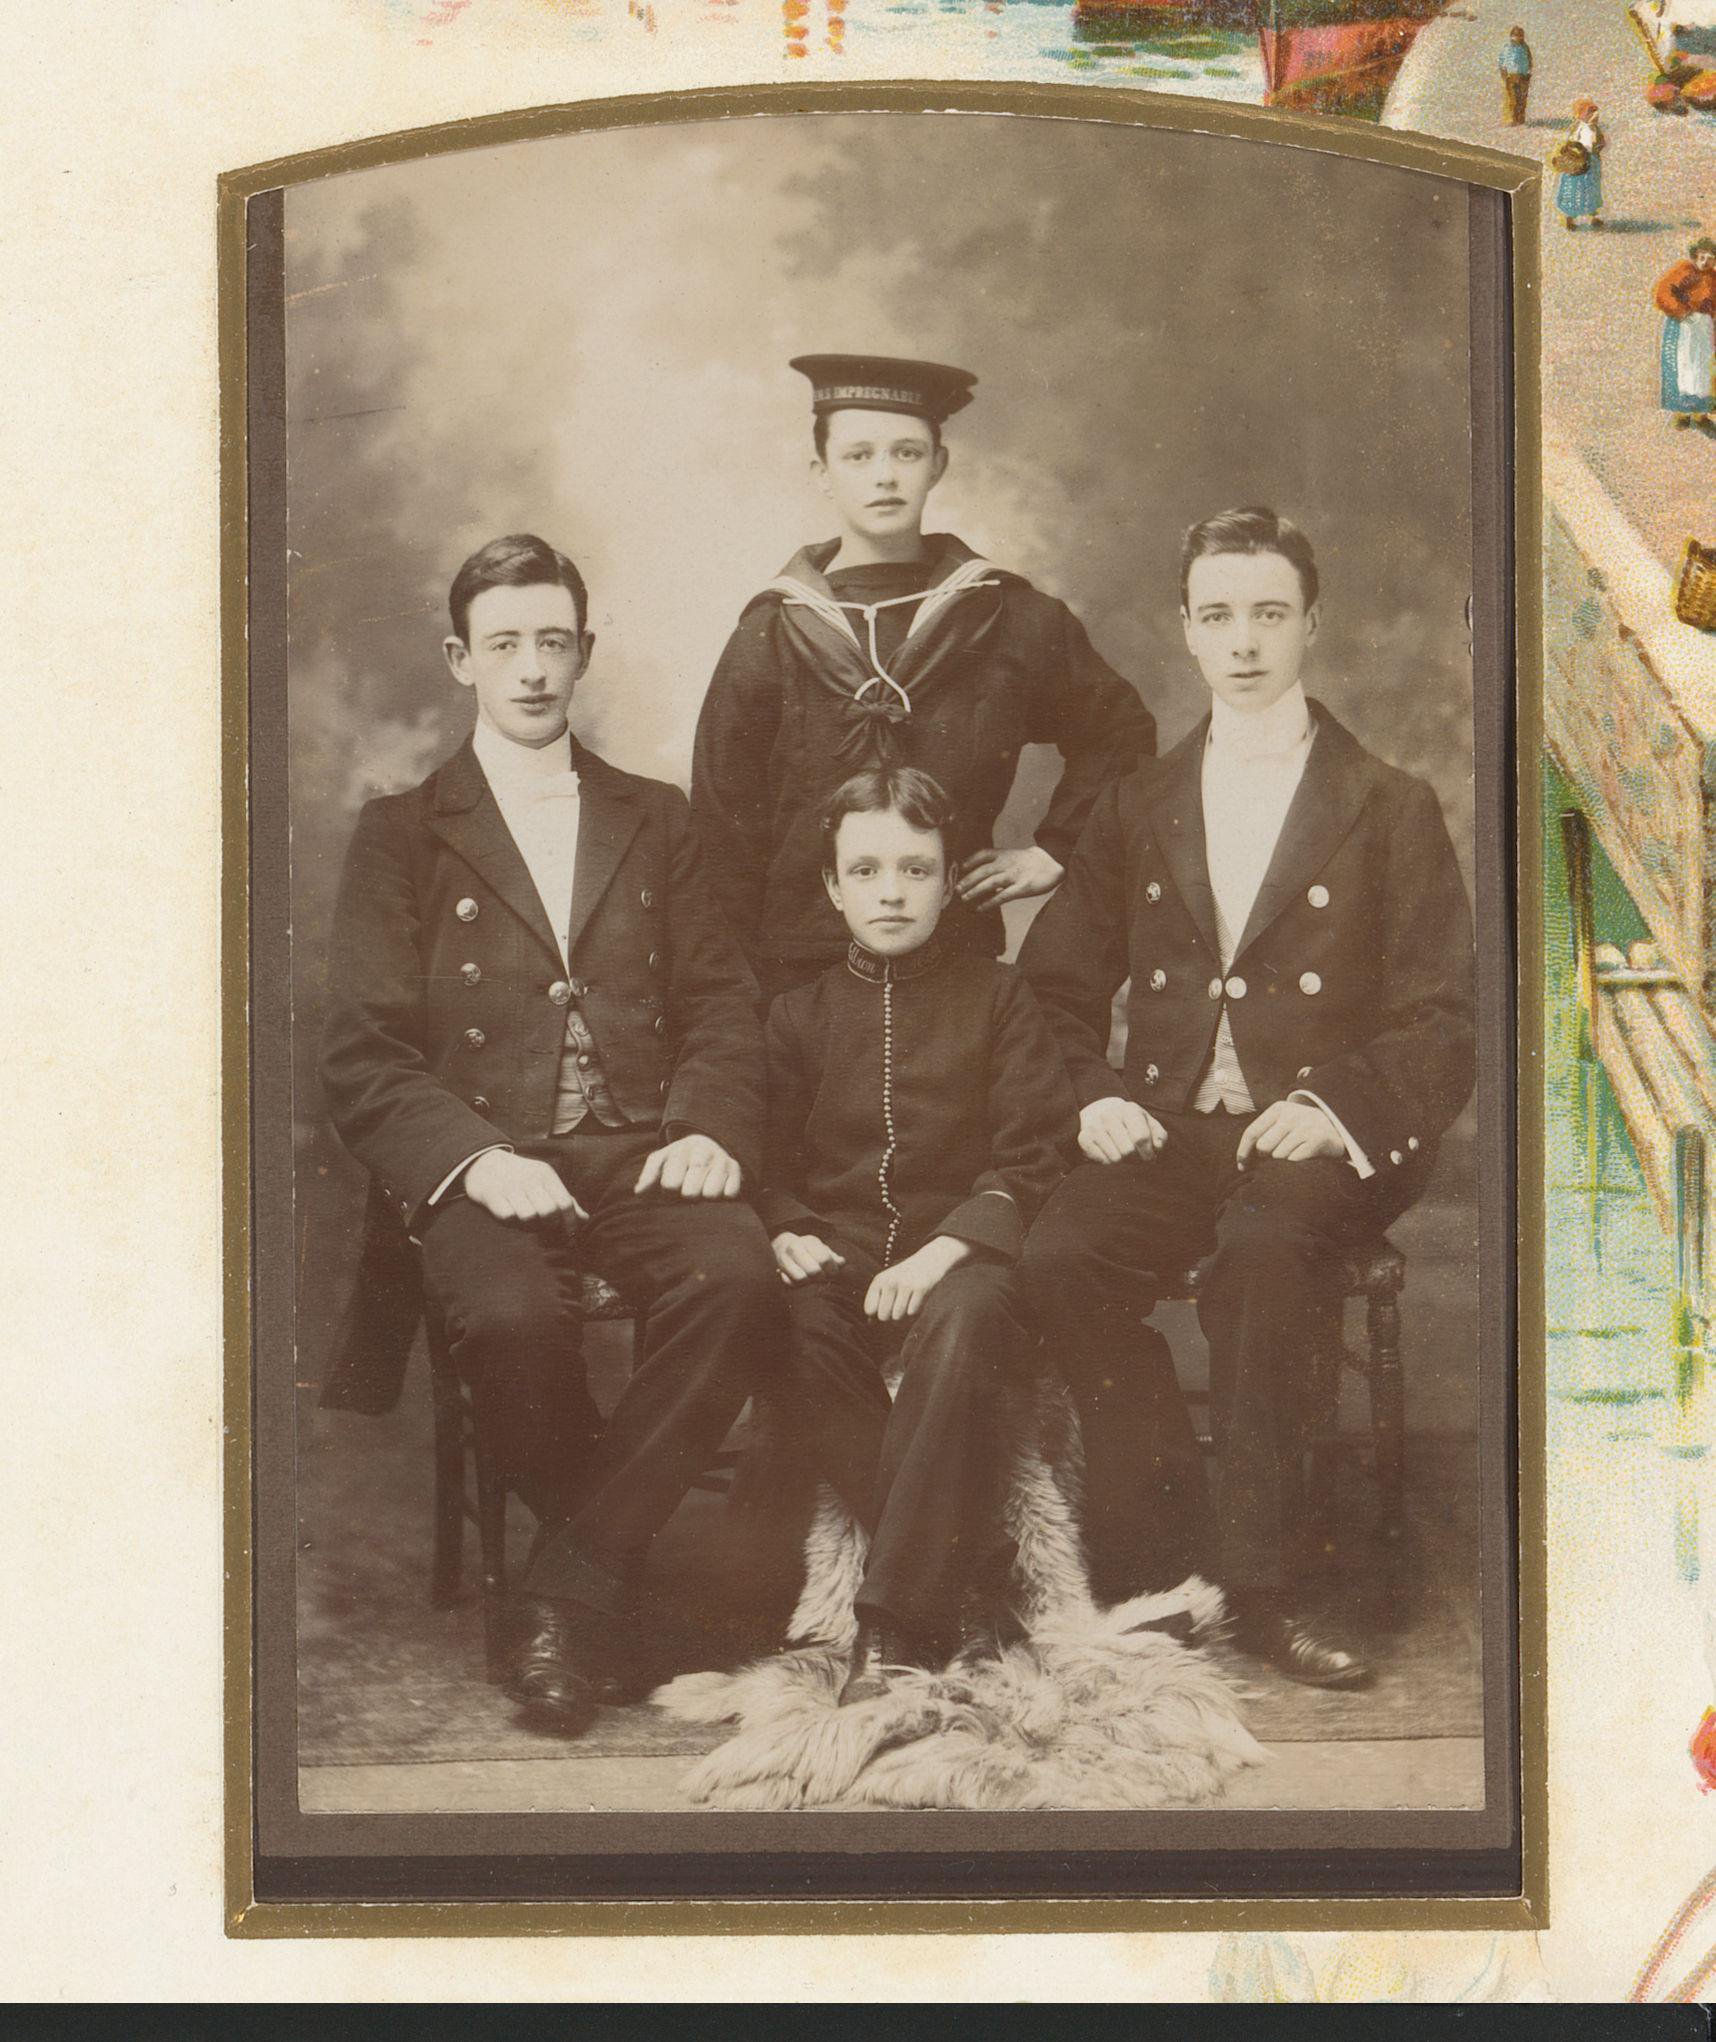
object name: album leaf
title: Portret van vier jongens in maritieme kleding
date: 1880-1915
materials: cardboard, photographic support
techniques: collodion silver print, four-color autotype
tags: harbour, flowers, historical persons, youth, adolescent, ships (in general)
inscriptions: name: ‘G. Austin/ 70, Seaside/ Eastbourne’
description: De foto is omlijst door bloemen en een gezicht op een haven met schepen. Dit blad maakt deel uit van een album.